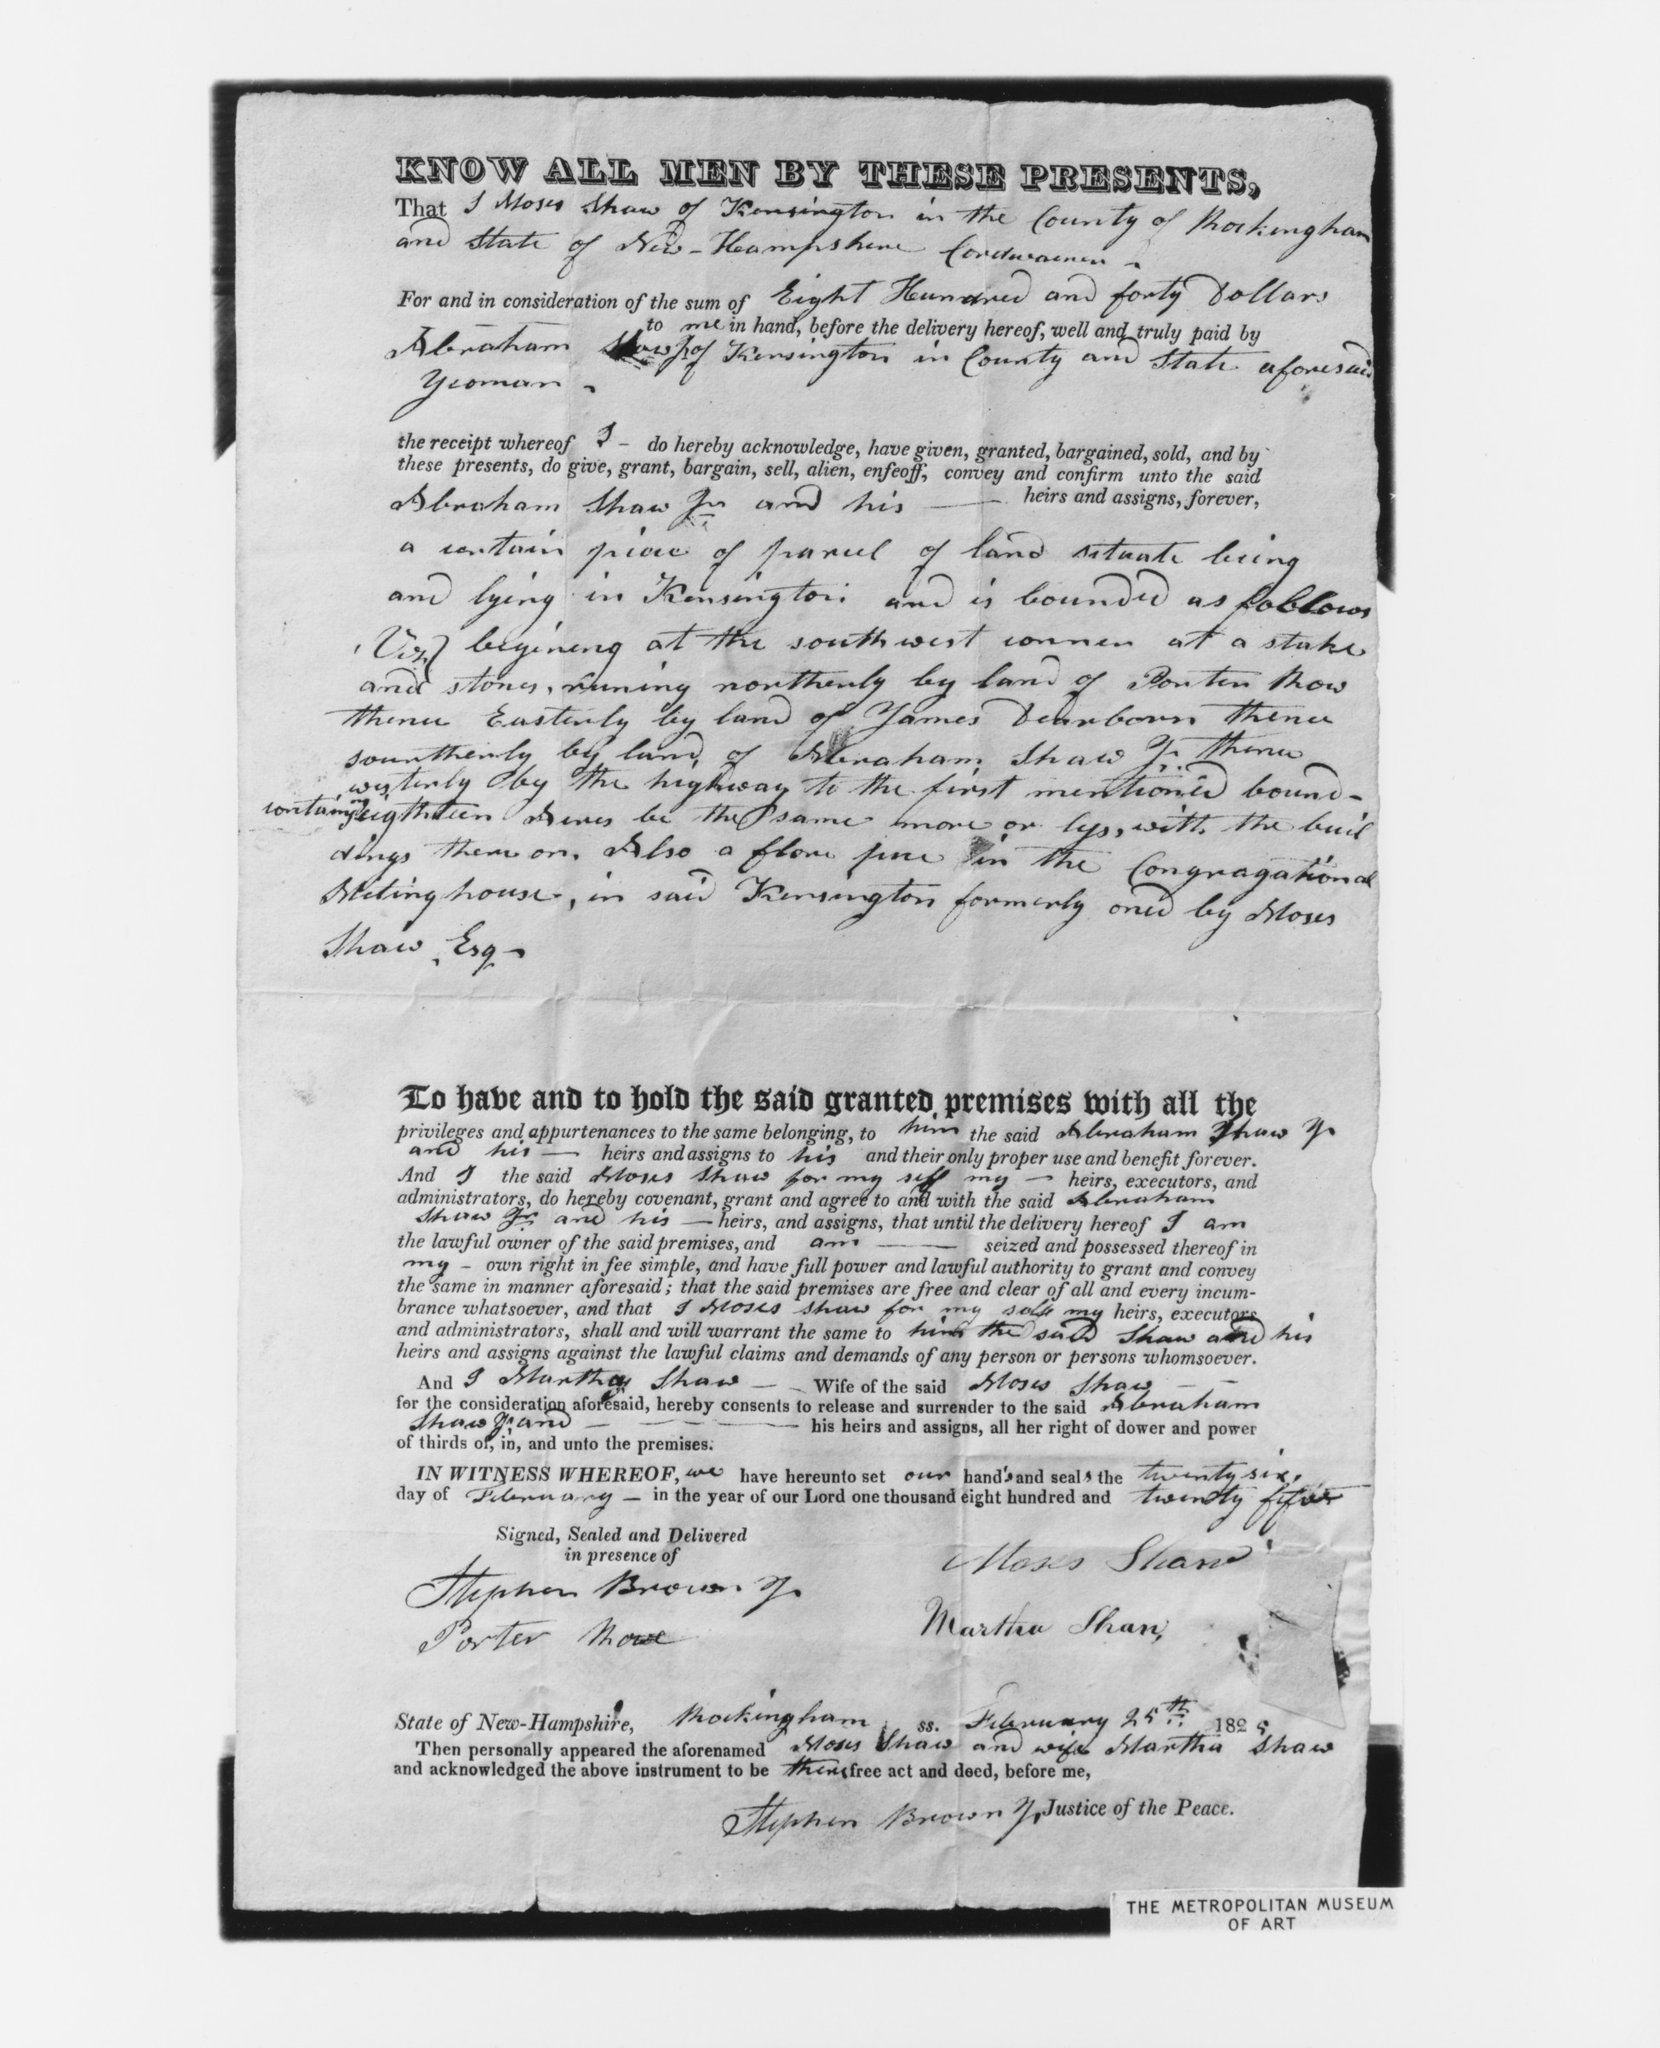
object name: manuscript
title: Manuscript Deed for Shaw Homestead, Kensington, New Hampshire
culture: american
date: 1825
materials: paper, parchment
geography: united states